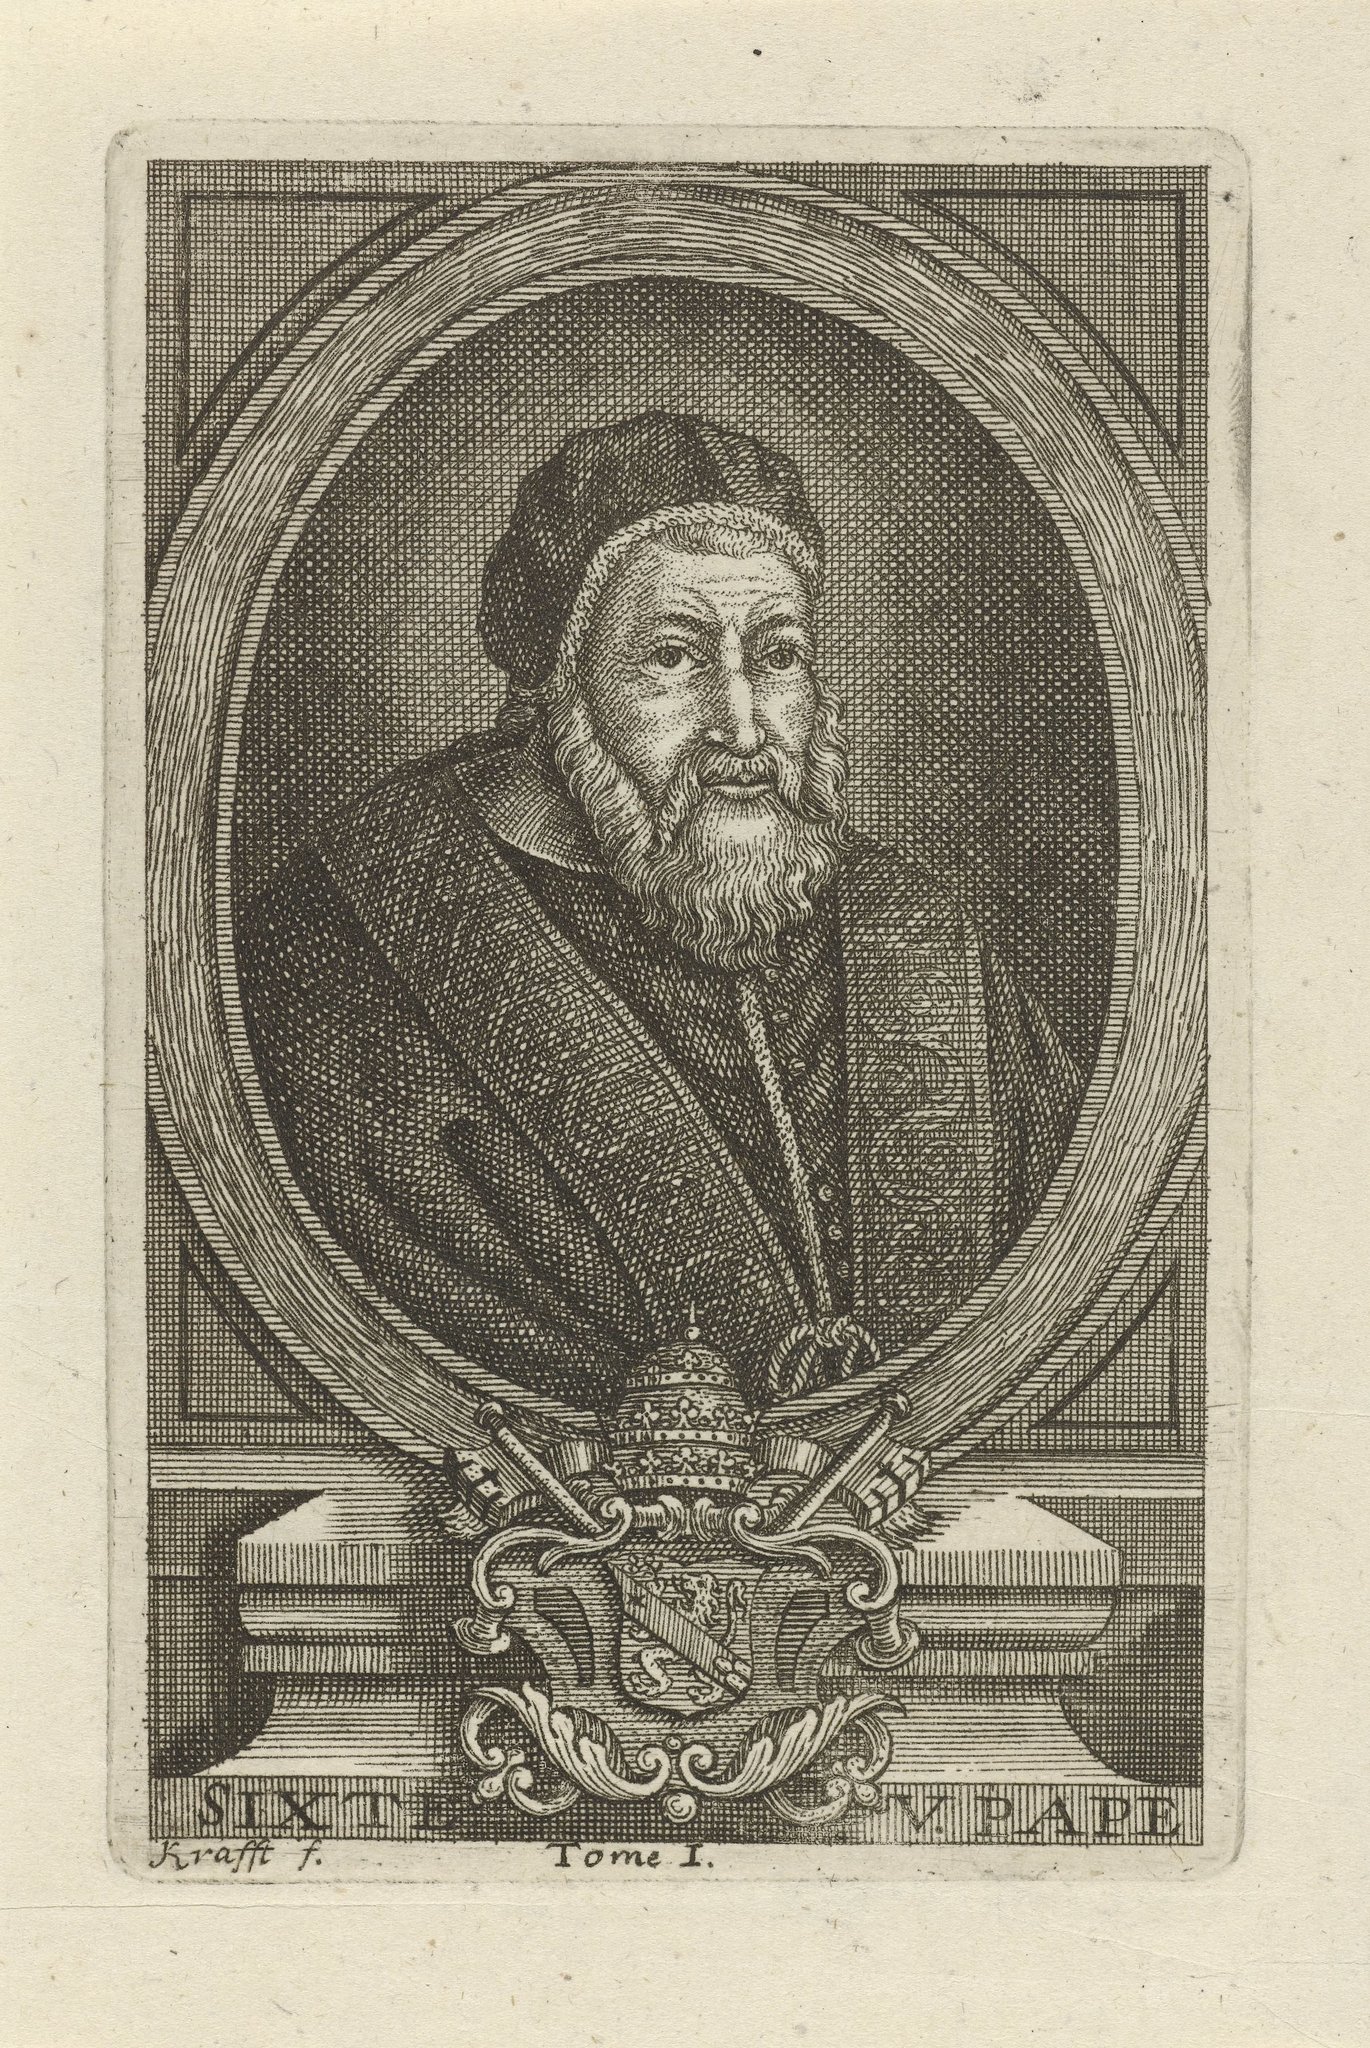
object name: print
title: Portret van Sixtus V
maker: jan lauwryn krafft (i)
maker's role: print maker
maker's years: 1694-1785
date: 1704-1765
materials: paper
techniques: engraving, etching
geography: southern netherlands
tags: sixtus v, historical persons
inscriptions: collector's mark: Lugt 2228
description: Portretbuste van paus Sixtus V, gehuld in zijn pauselijk gewaad. Onder het portret zijn pauselijke wapen.